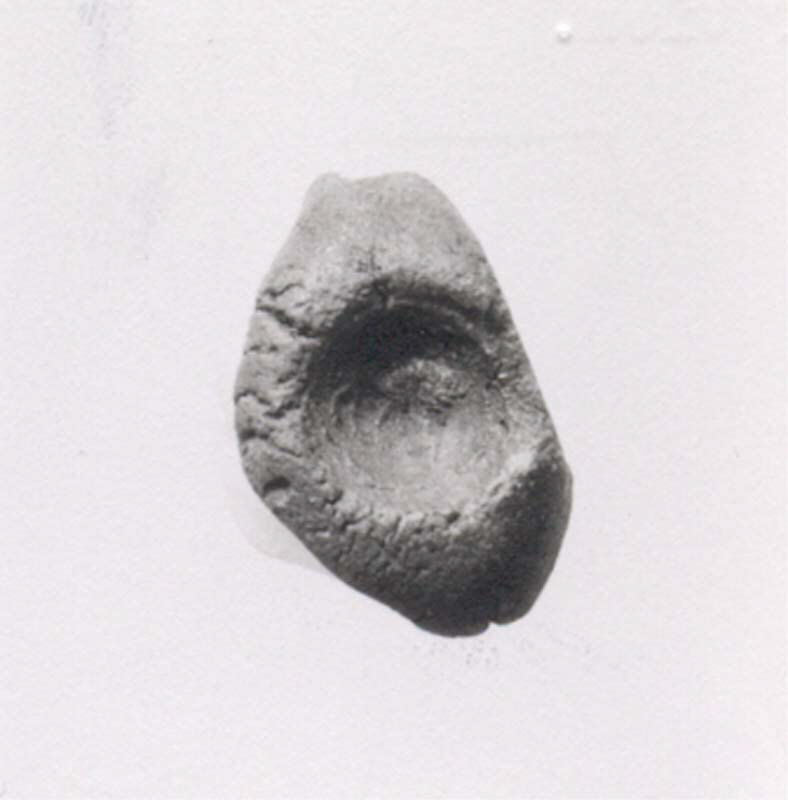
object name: sealing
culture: sasanian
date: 601-700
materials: clay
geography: iran